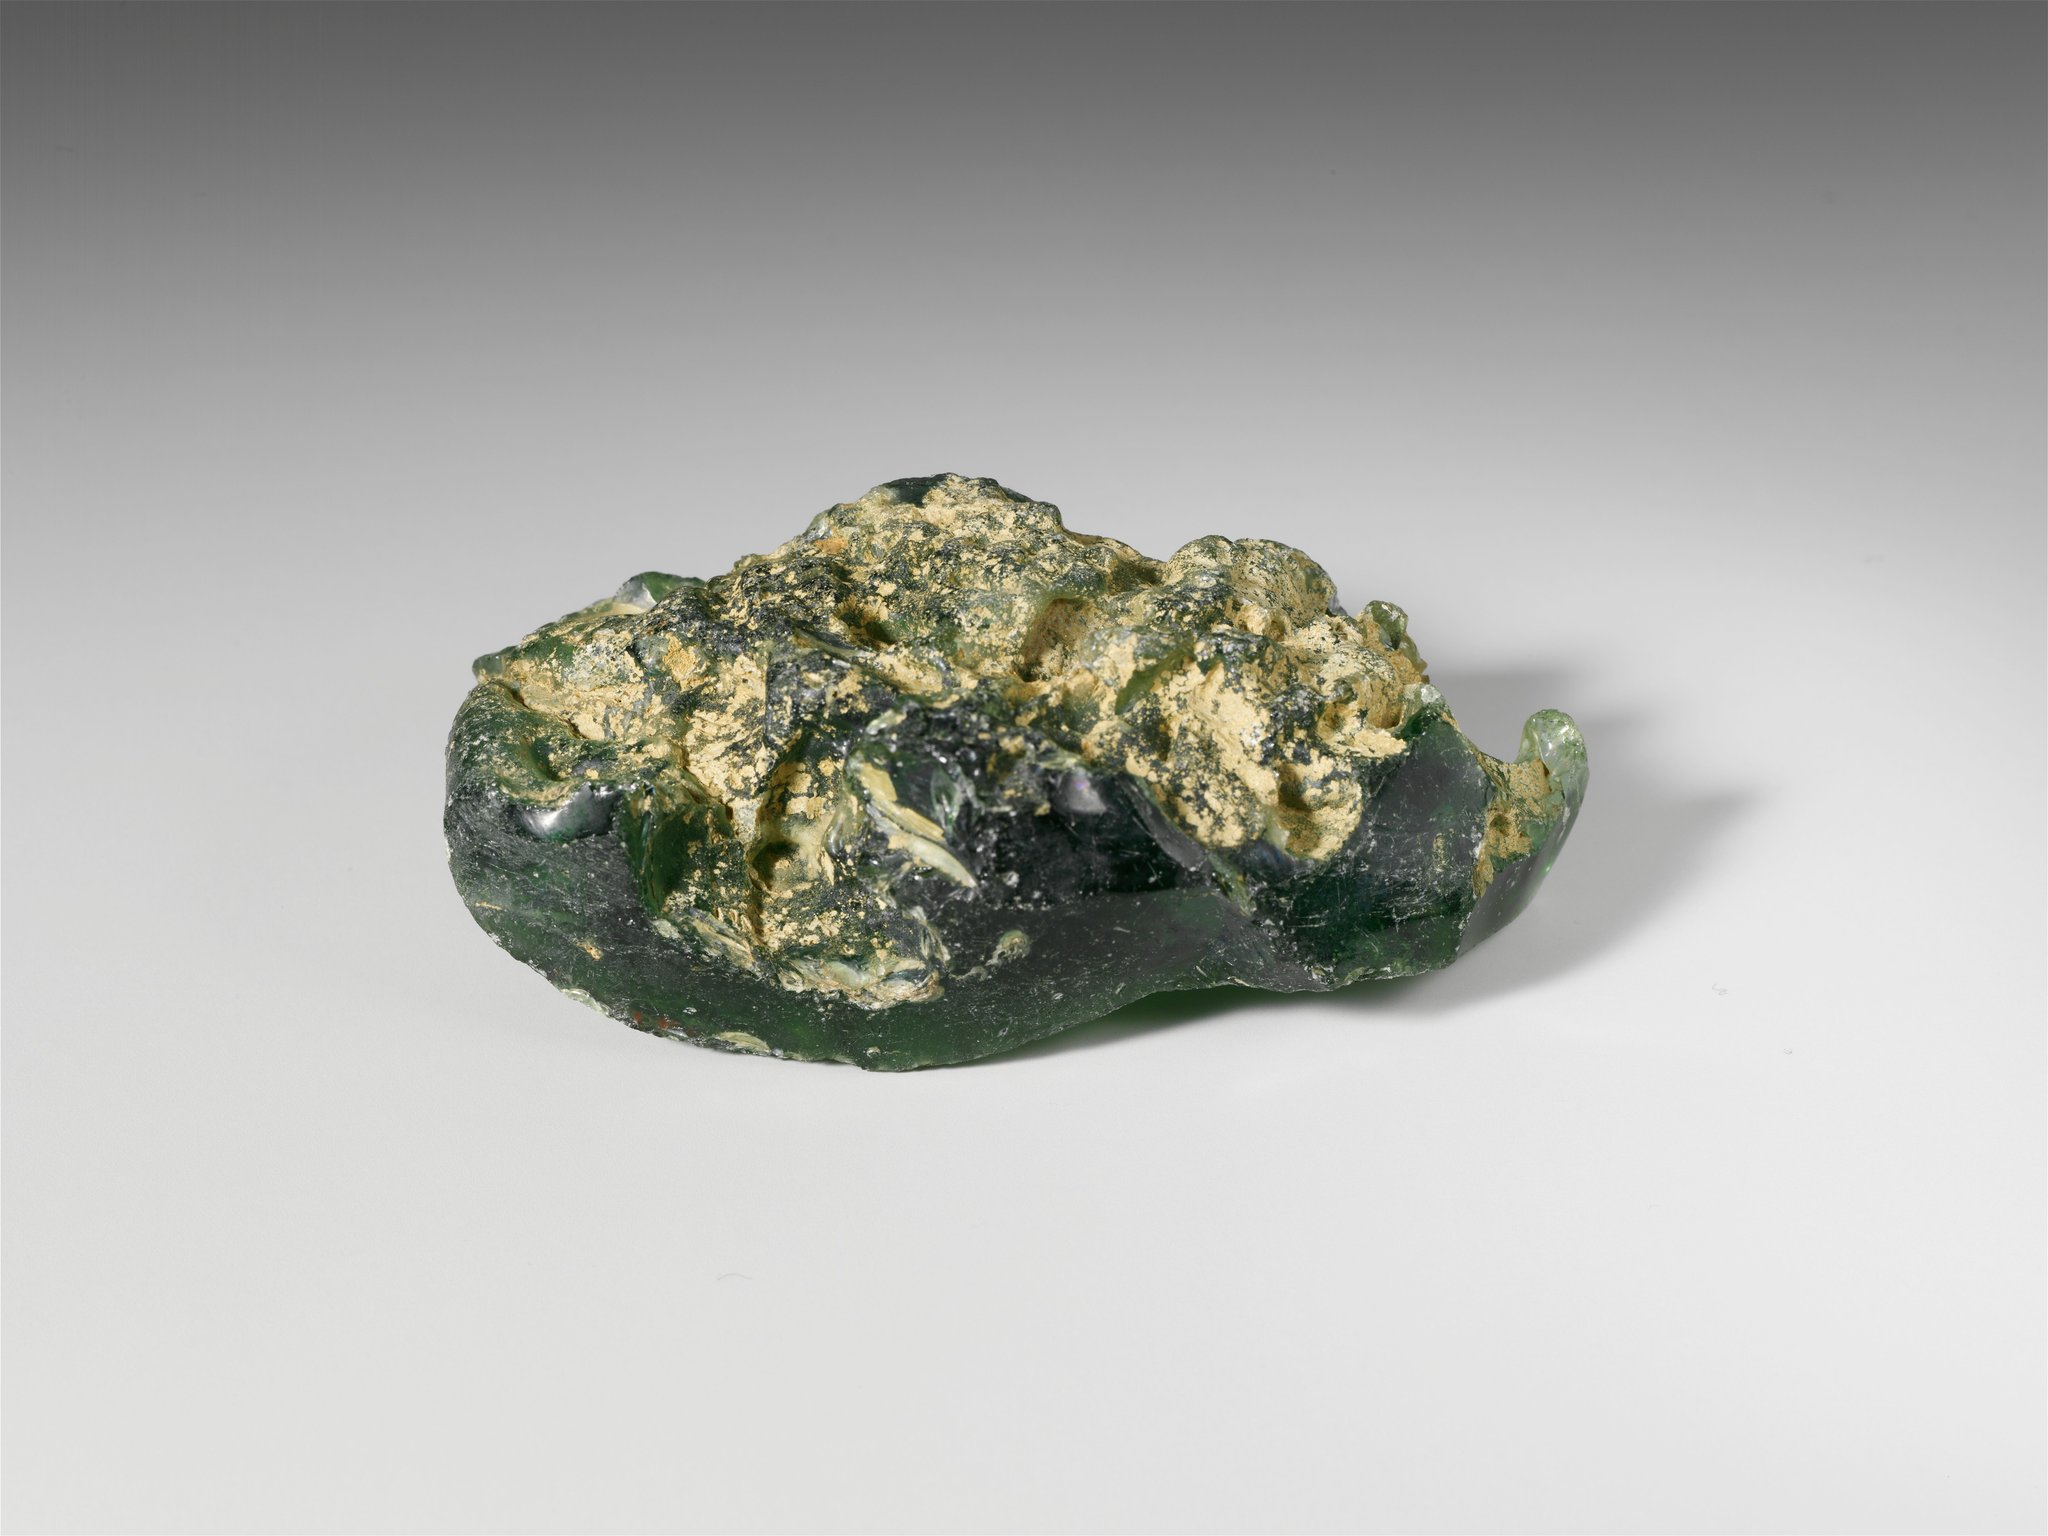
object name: fragment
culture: american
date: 1701-1800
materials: glass, lead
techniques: glassblowing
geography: united states